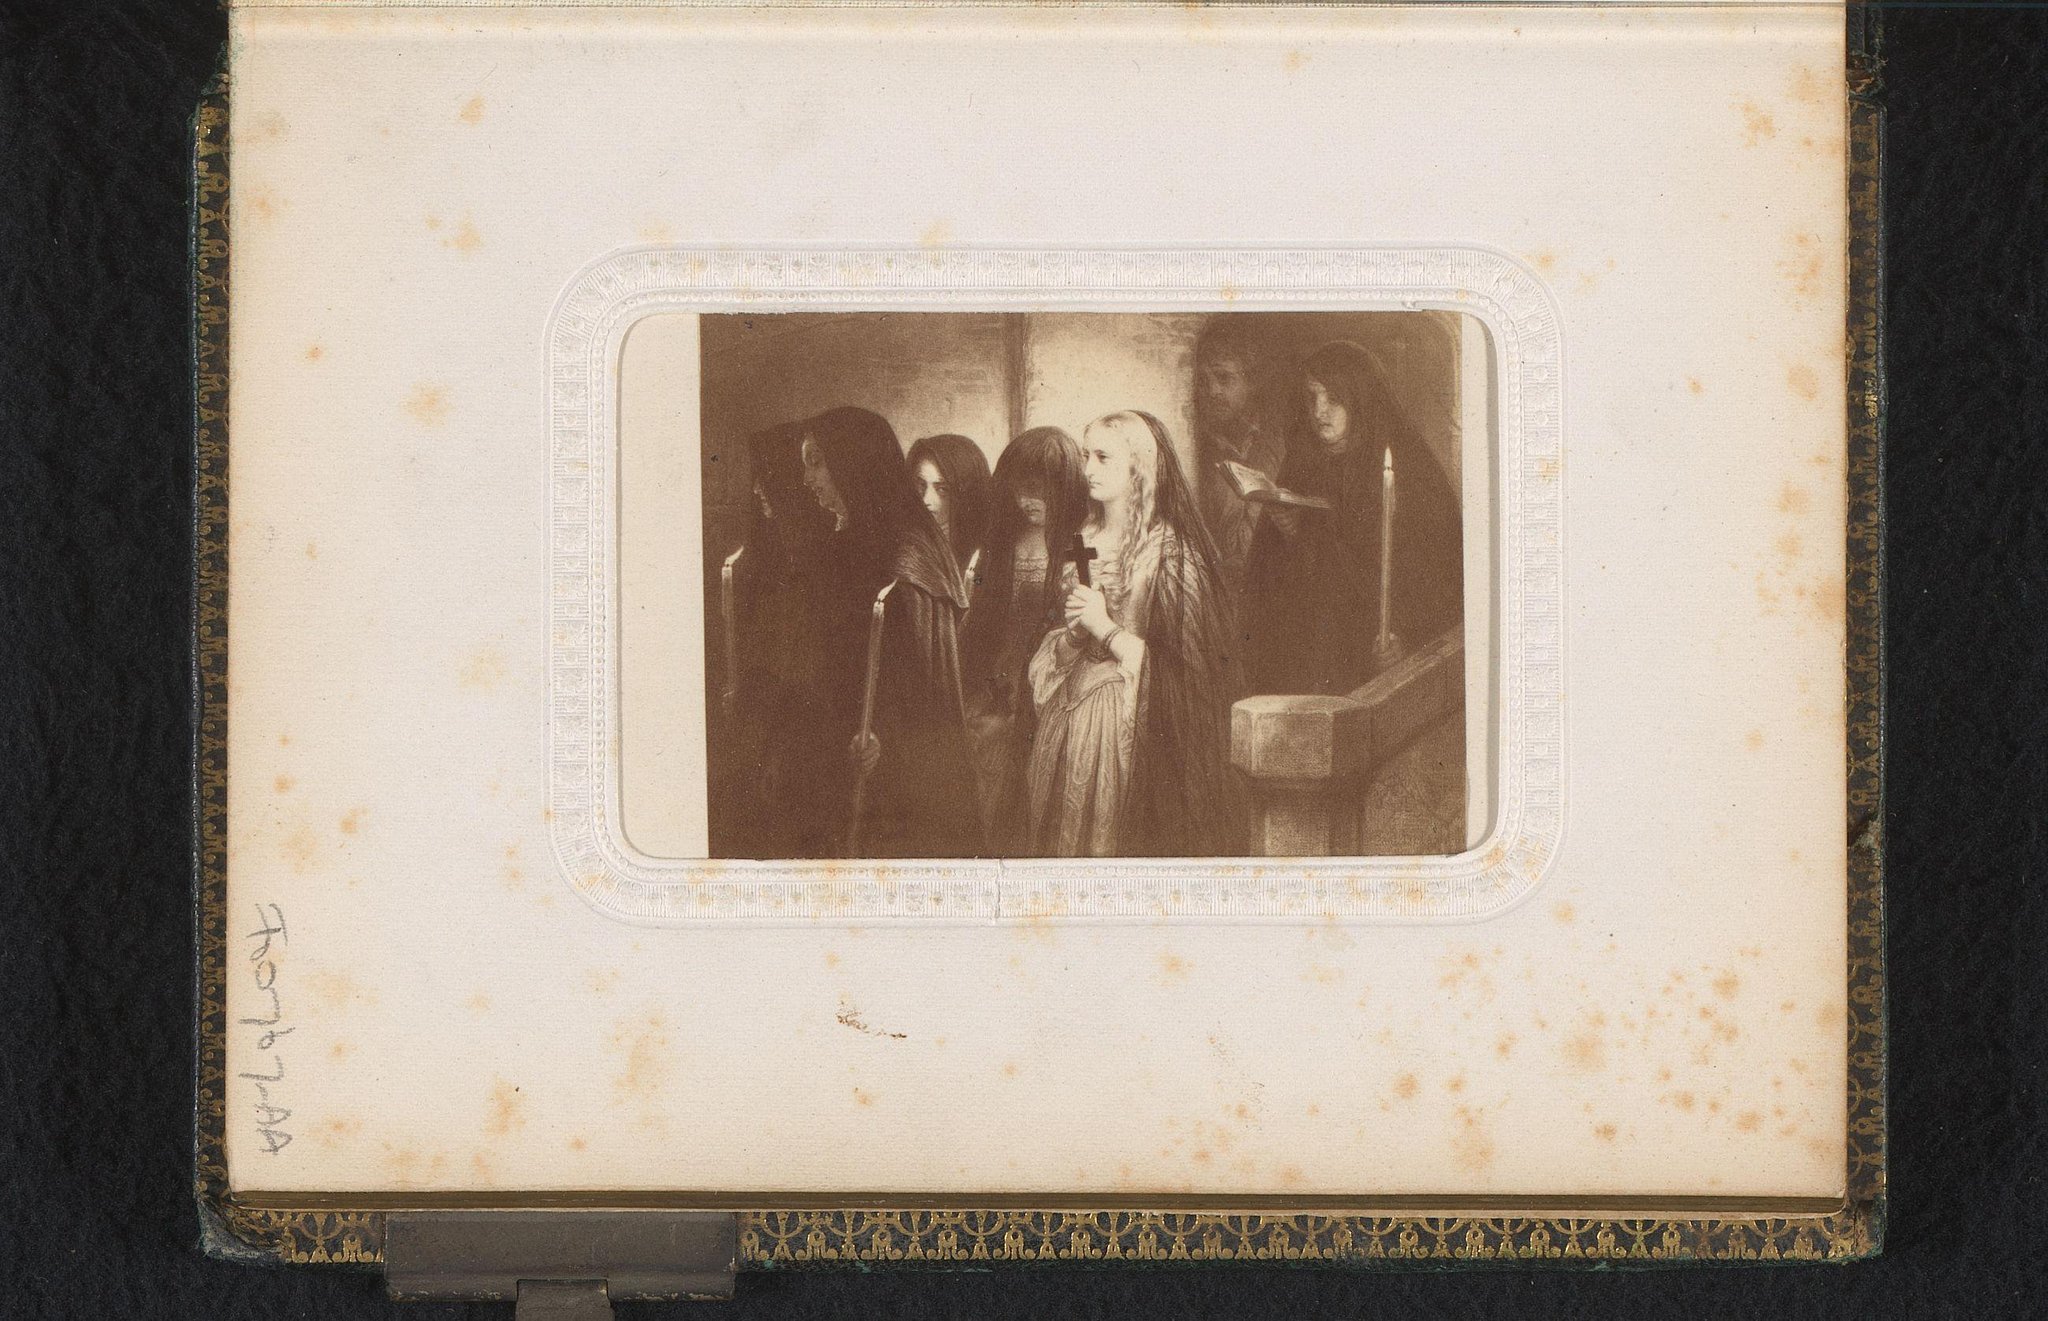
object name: photograph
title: Fotoreproductie van een schilderij van de verjaging van Beatrice Cenci door Paul Delaroche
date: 1861-1878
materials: cardboard, photographic support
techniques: albumen print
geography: paris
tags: banishment, exile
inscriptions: inscription: ‘PHOTOGRAPHIE GOUPIL & Cie/ PARIS, 19, Bd Montmartre./ LONDRES-LA HAYE-BERLIN-NEW YORK.’